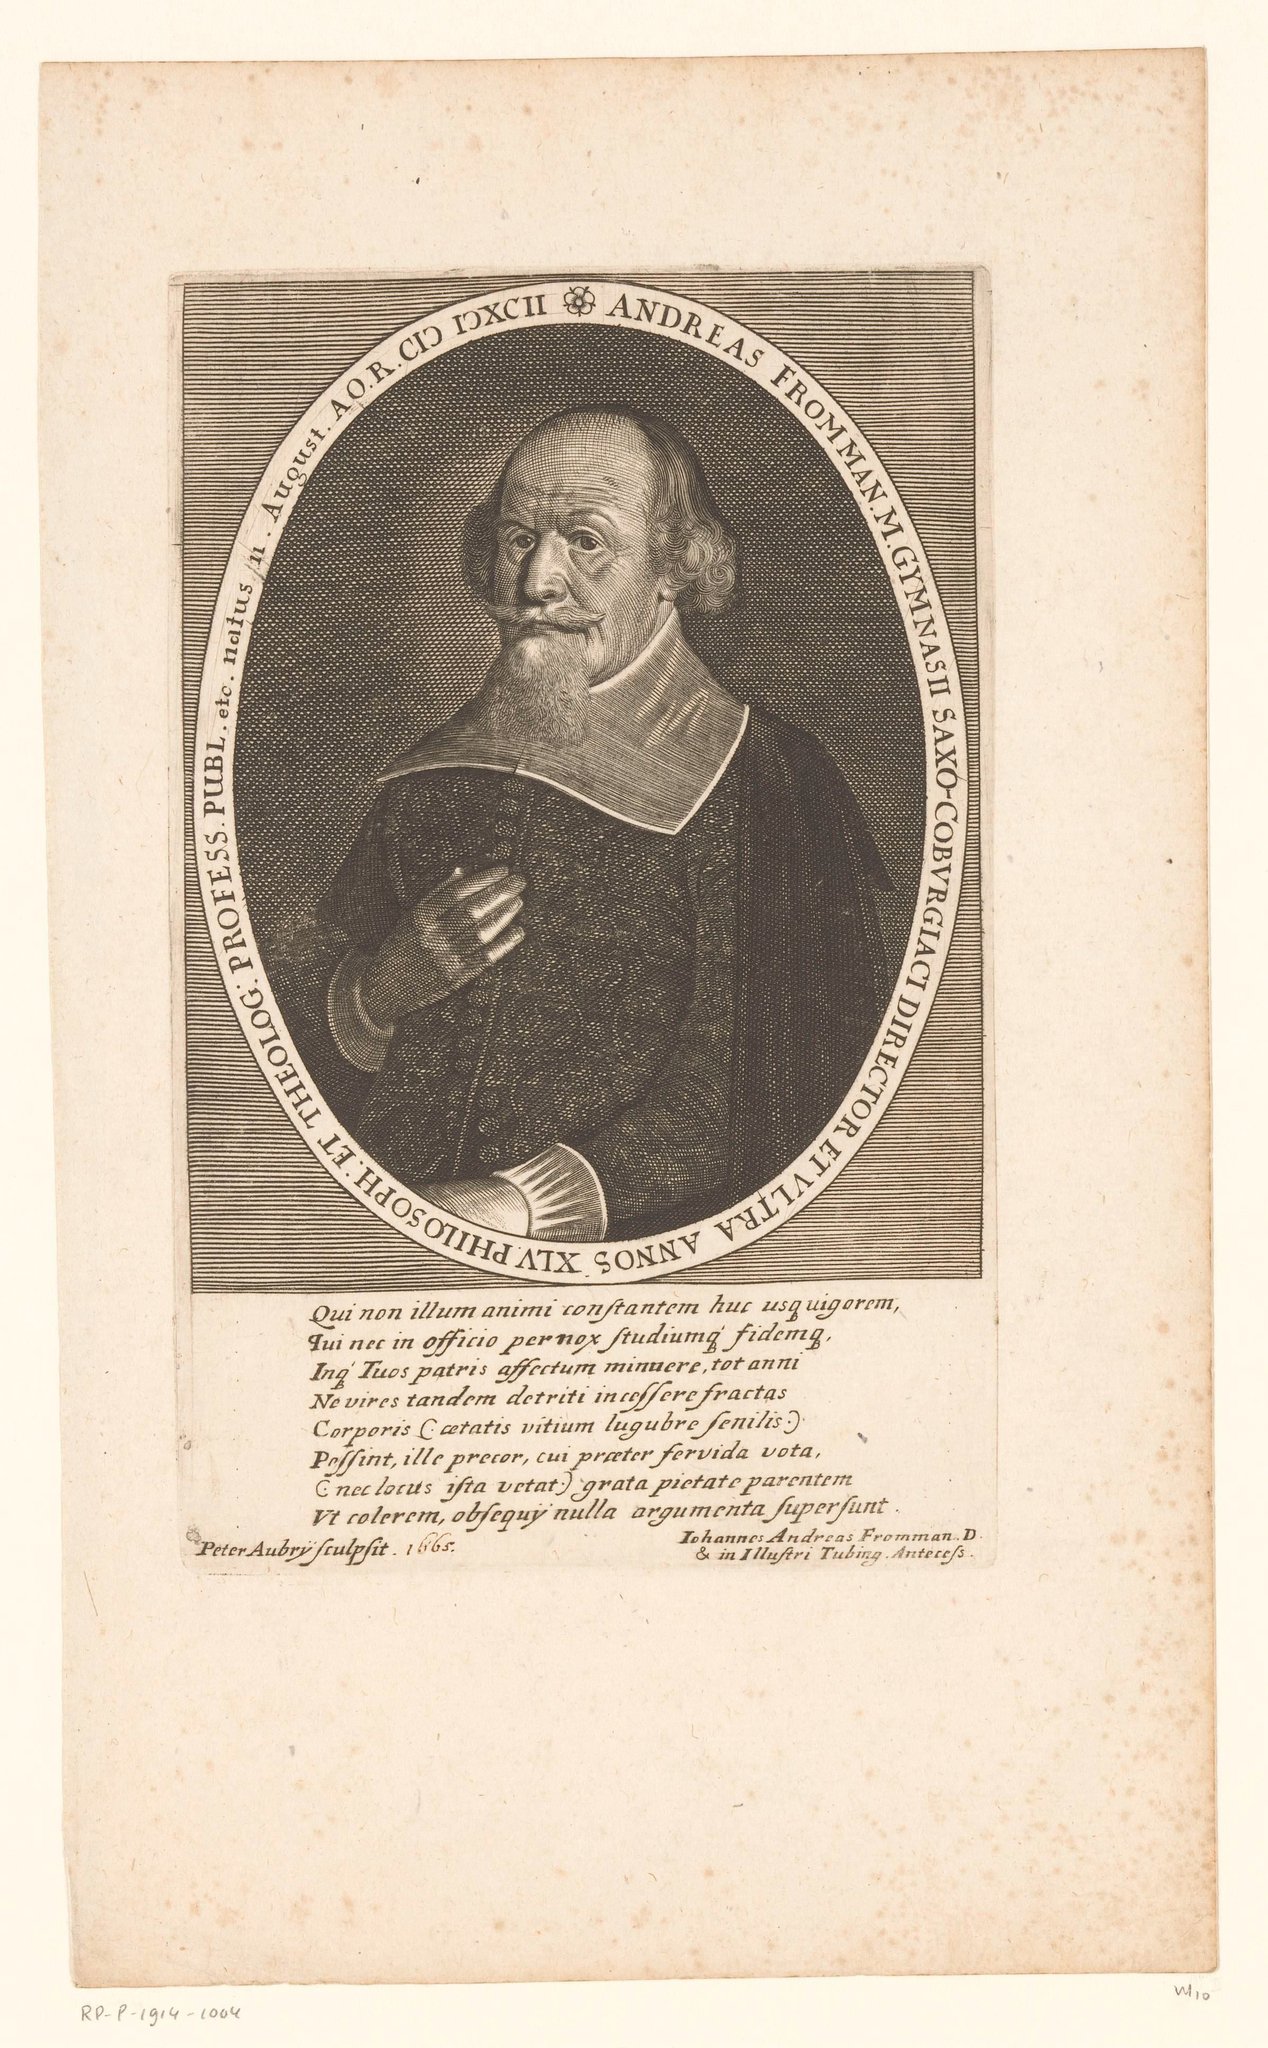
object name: print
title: Portret van Andreas Frommann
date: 1665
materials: paper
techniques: engraving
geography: tübingen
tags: historical persons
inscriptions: collector's mark: Lugt 2228